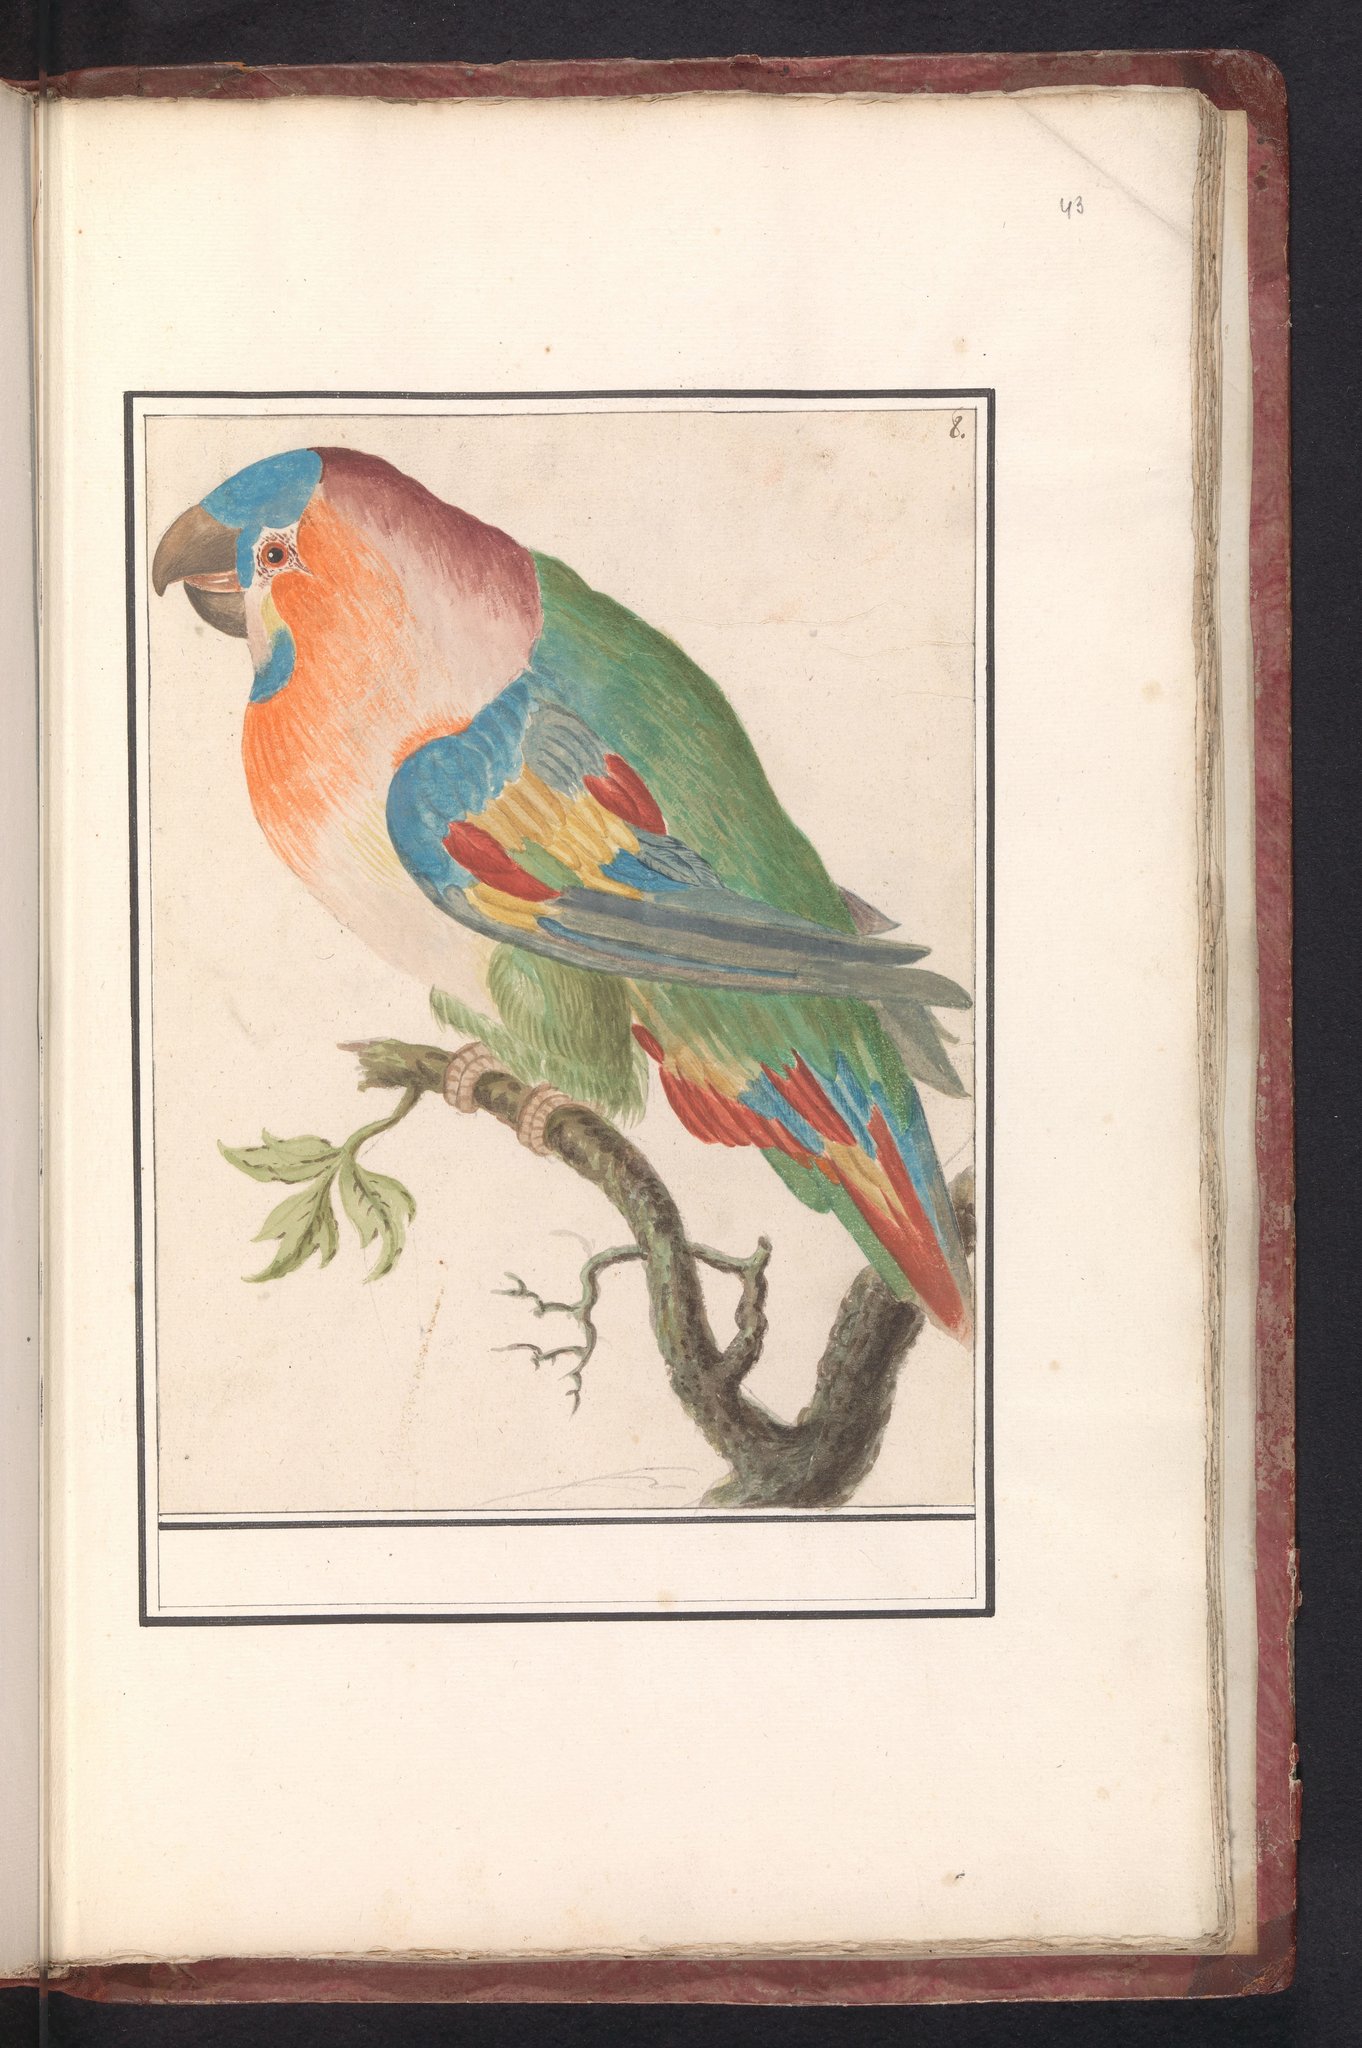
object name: drawing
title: Papegaai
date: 1596-1610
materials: paint, paper, pencil, watercolor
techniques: brush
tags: ornamental birds: parrot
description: Papegaai. Genummerd rechtsboven: 8. Onderdeel van het tweede album met tekeningen van vogels. Vierde van twaalf albums met tekeningen van dieren, vogels en planten bekend rond 1600, gemaakt in opdracht van keizer Rudolf II. Met toelichting in Nederlands, Latijn en Frans.